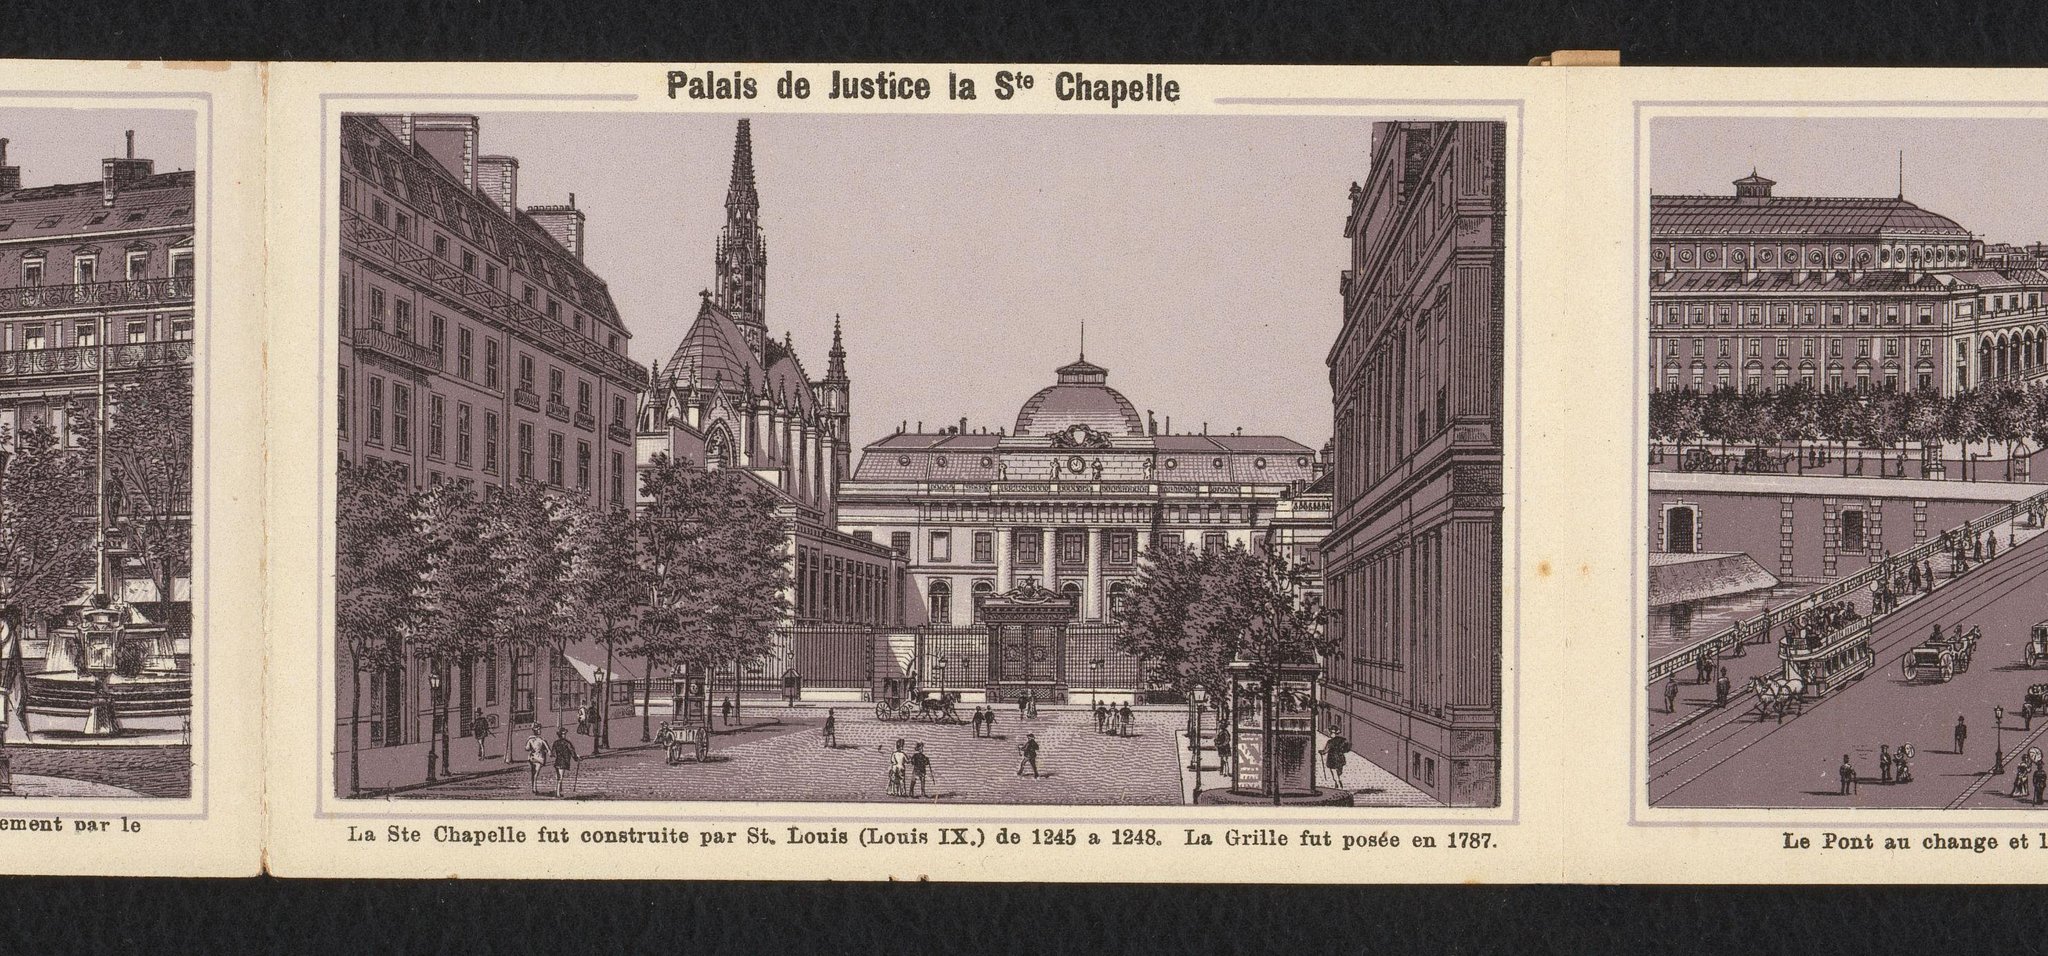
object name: print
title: Palais de Justice la Ste. Chapelle. La Ste. Chapelle fut construite par St. Louis (Louis IX) de 1245 à 1248. La Grille fut posée en 1787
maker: Anonymous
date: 1890-1910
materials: cardboard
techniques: lithograph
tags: court building, church (exterior), city-view, and landscape with man-made constructions (+ city(-scape) with figures, staffage)